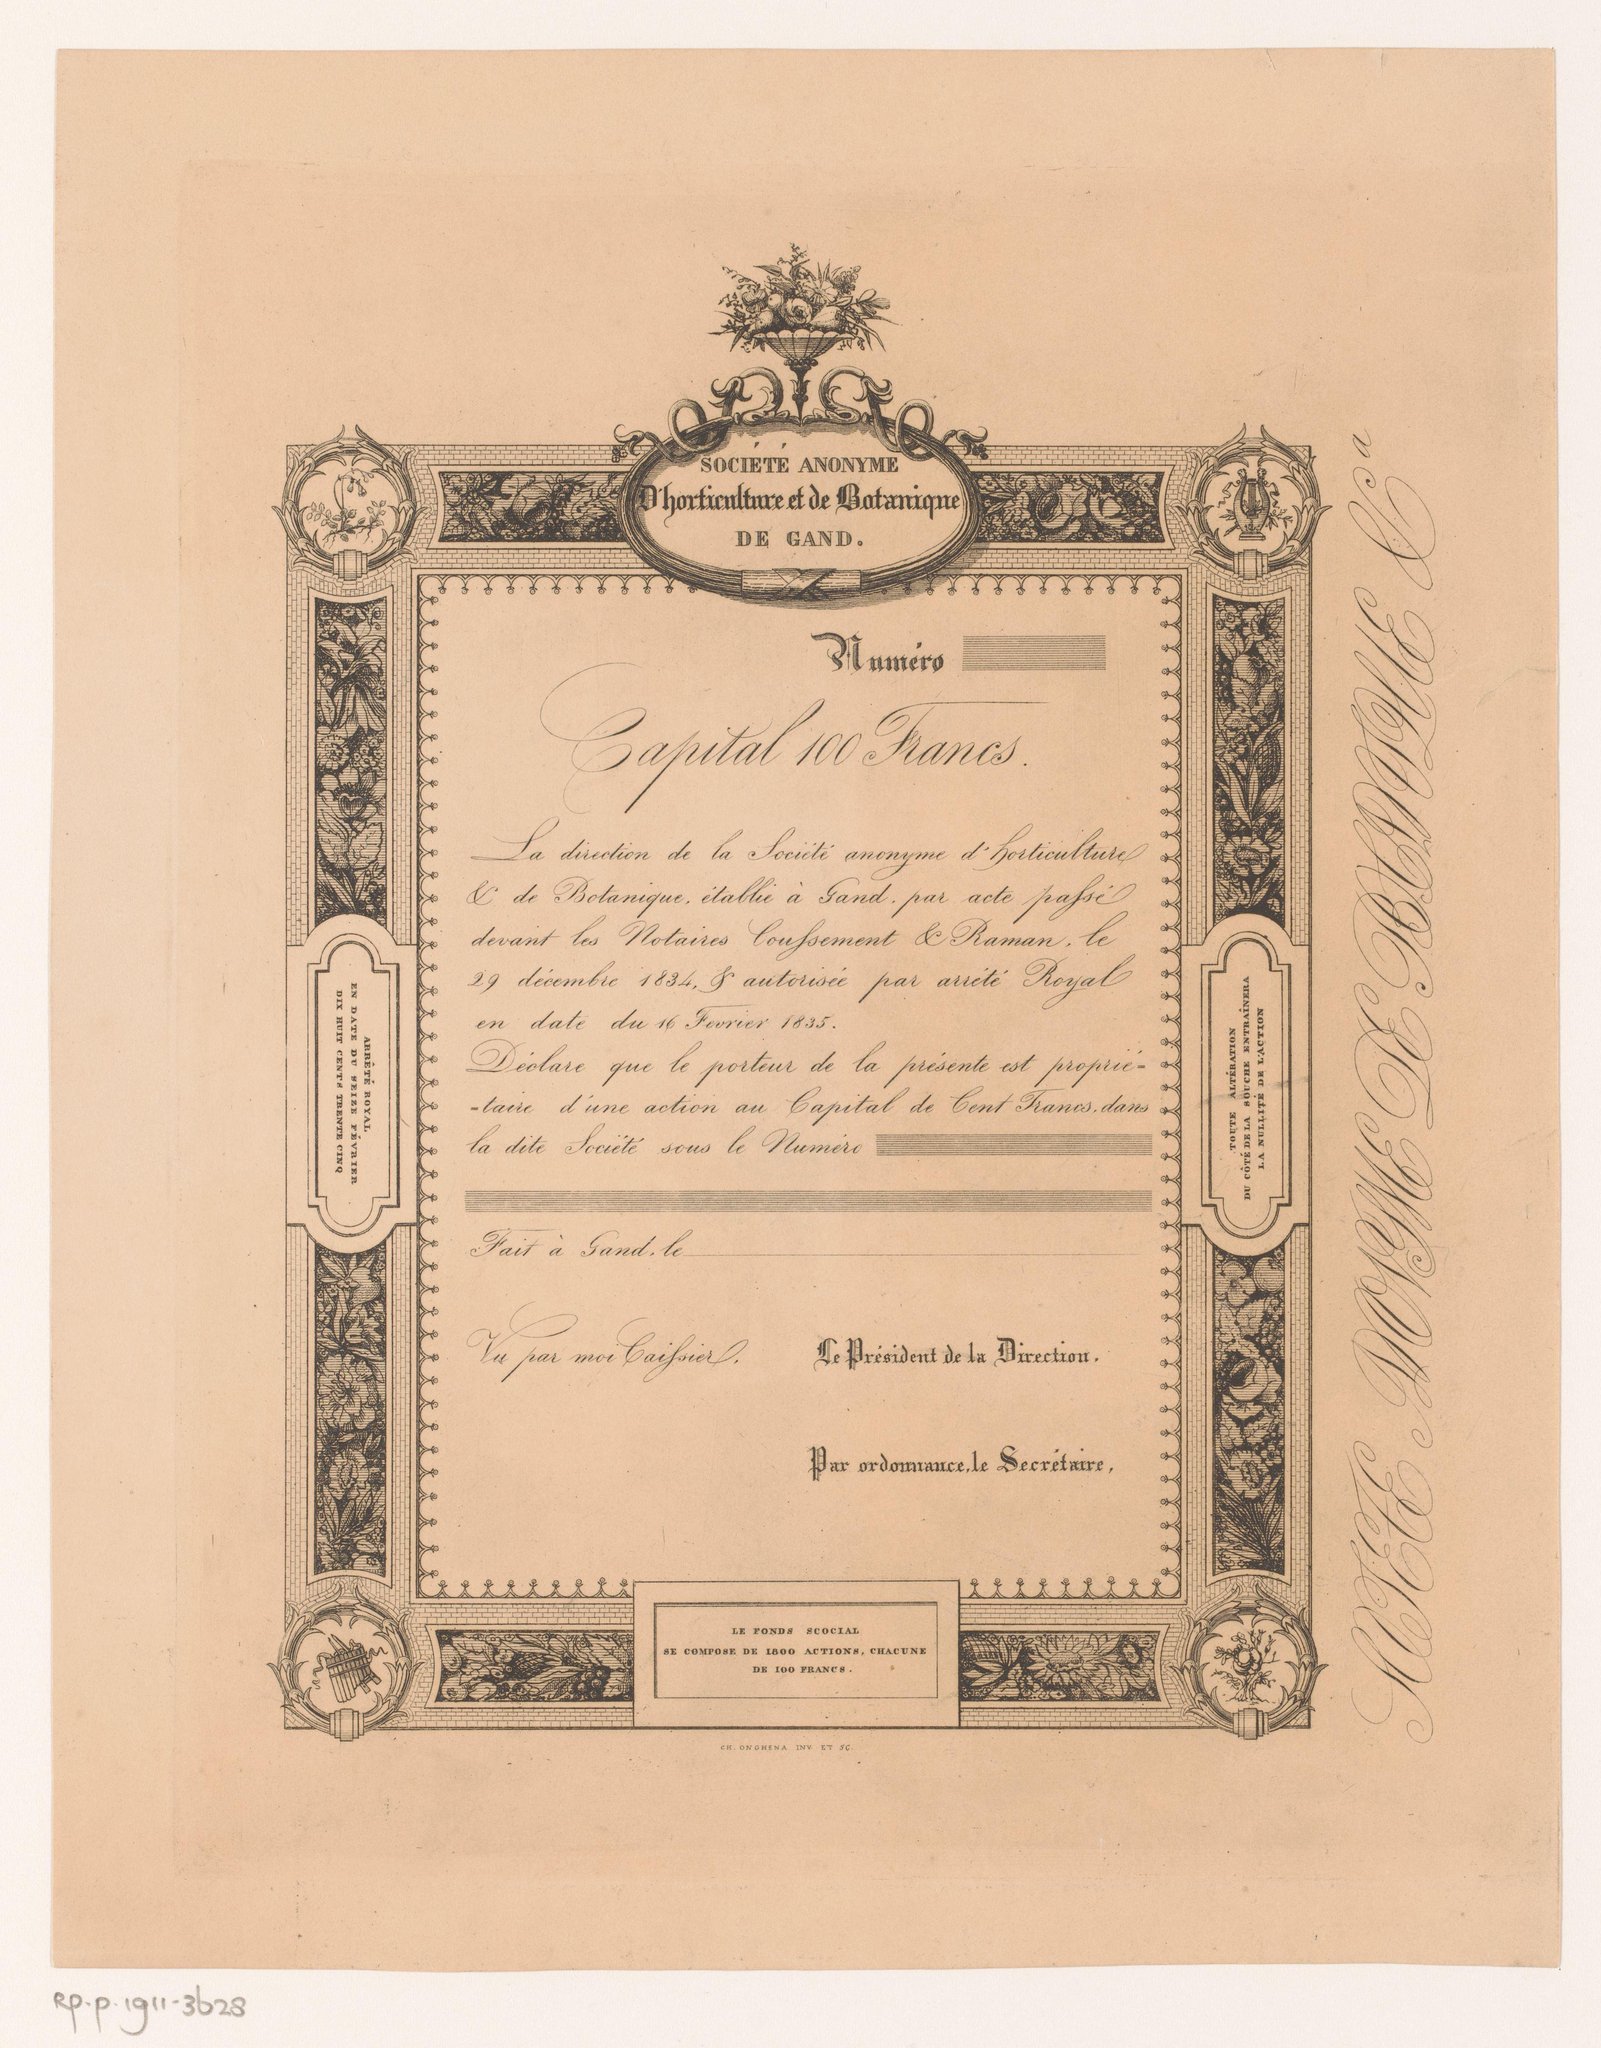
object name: print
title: Aandeel van de Societé anonyme d'Horticulture et de Botanique de Gand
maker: charles onghena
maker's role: print maker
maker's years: 1806-1886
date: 1835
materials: paper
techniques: engraving, etching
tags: stock exchange, stock-market, ghent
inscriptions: collector's mark: Lugt 2228